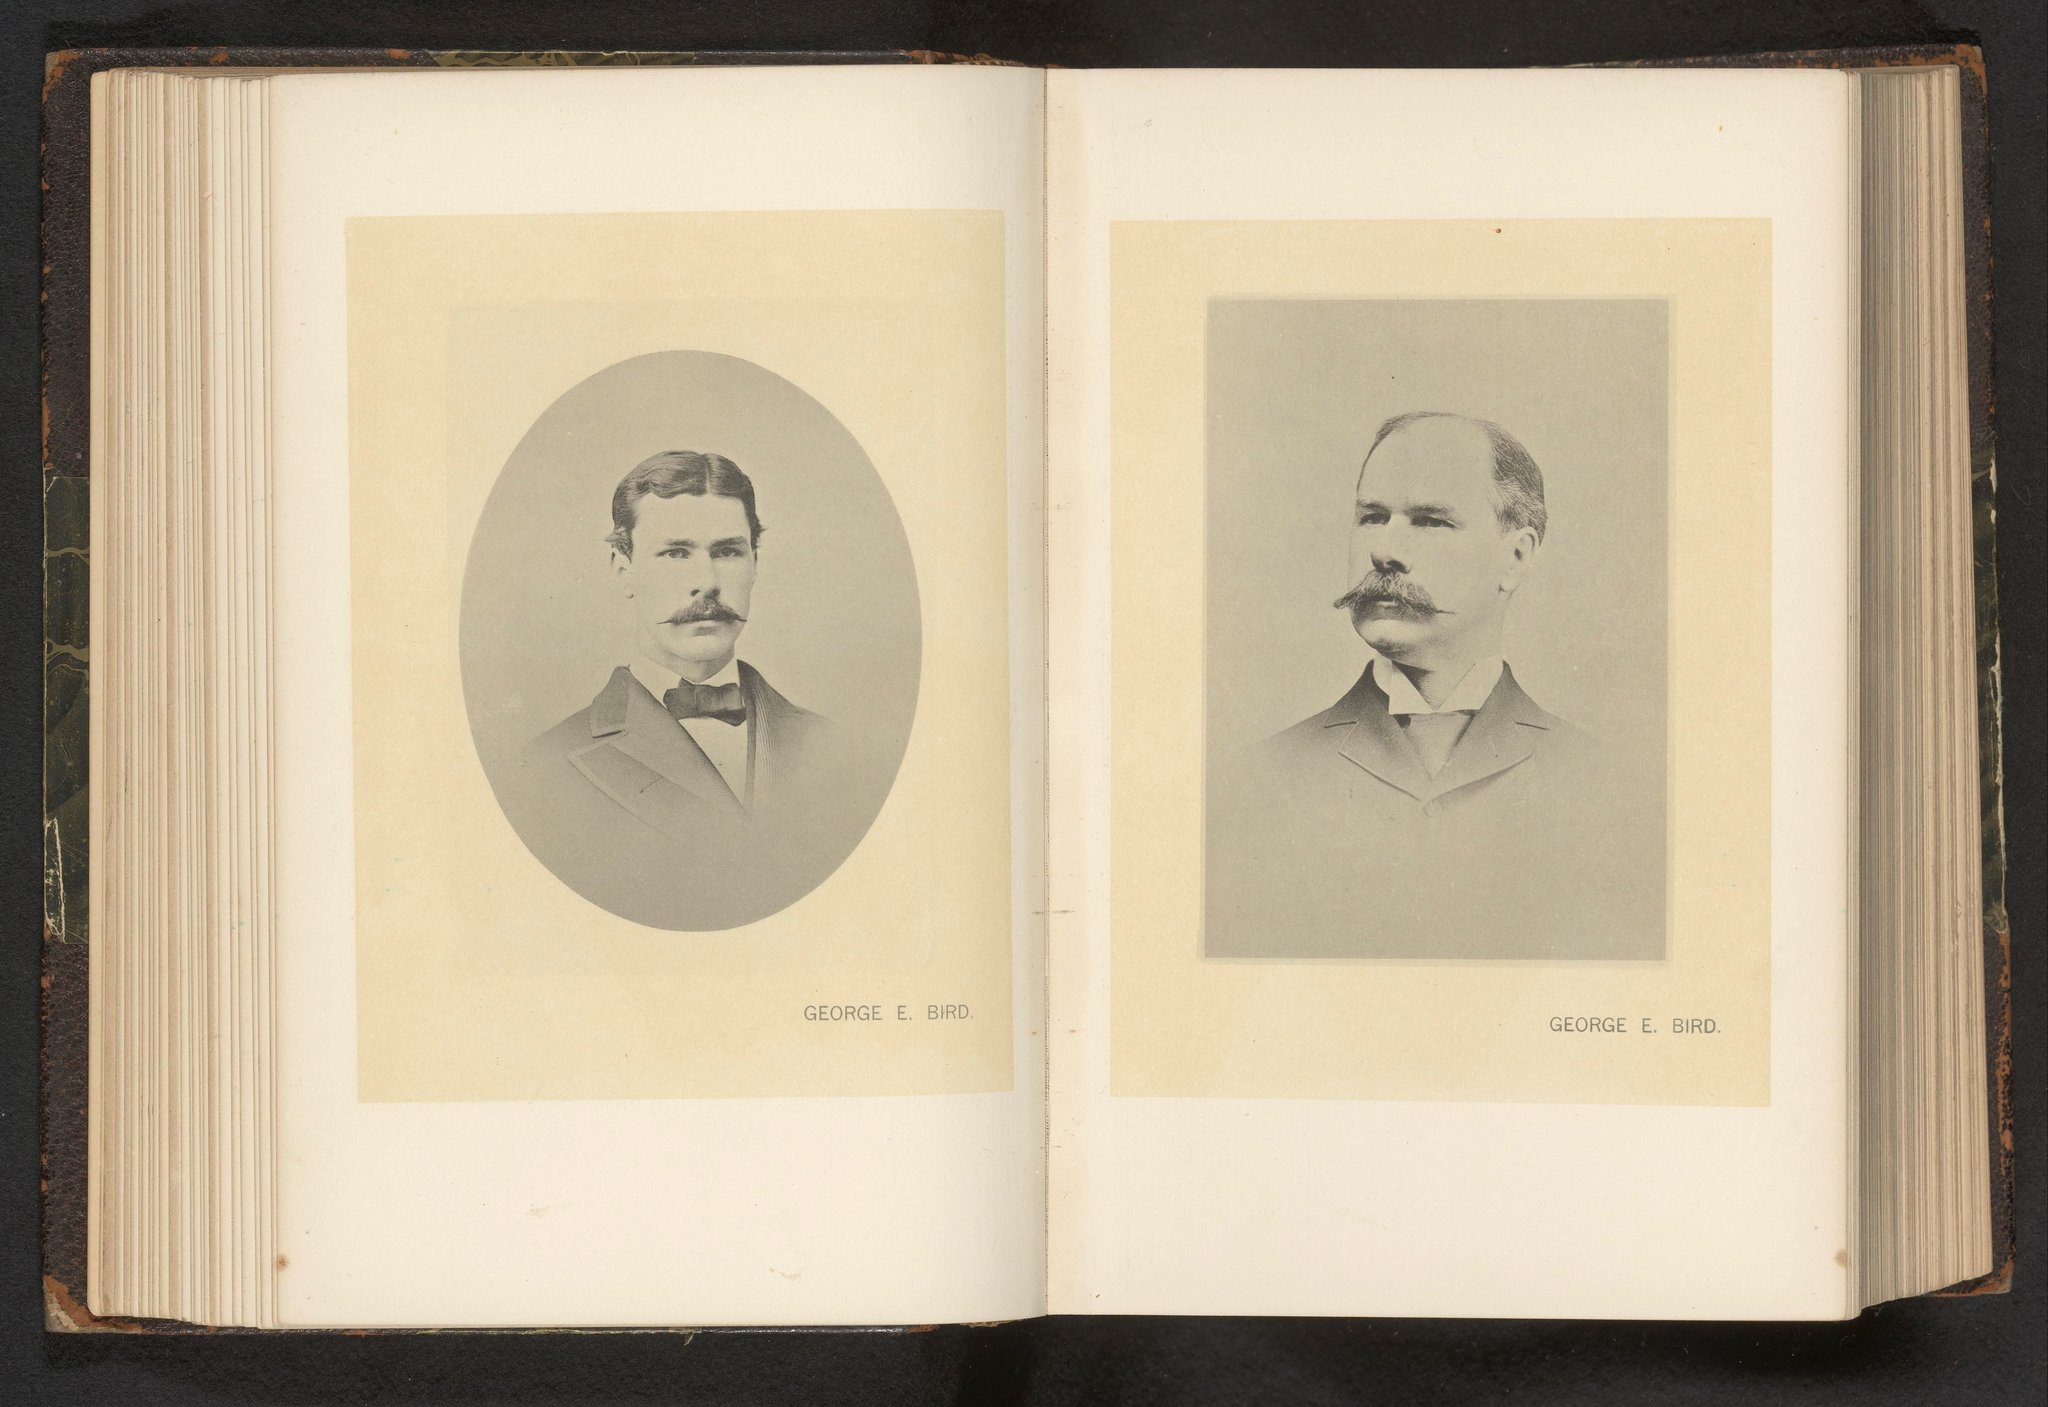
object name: photomechanical print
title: George E. Bird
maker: Anonymous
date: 1869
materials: paper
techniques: photoaquatint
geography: boston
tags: adult man